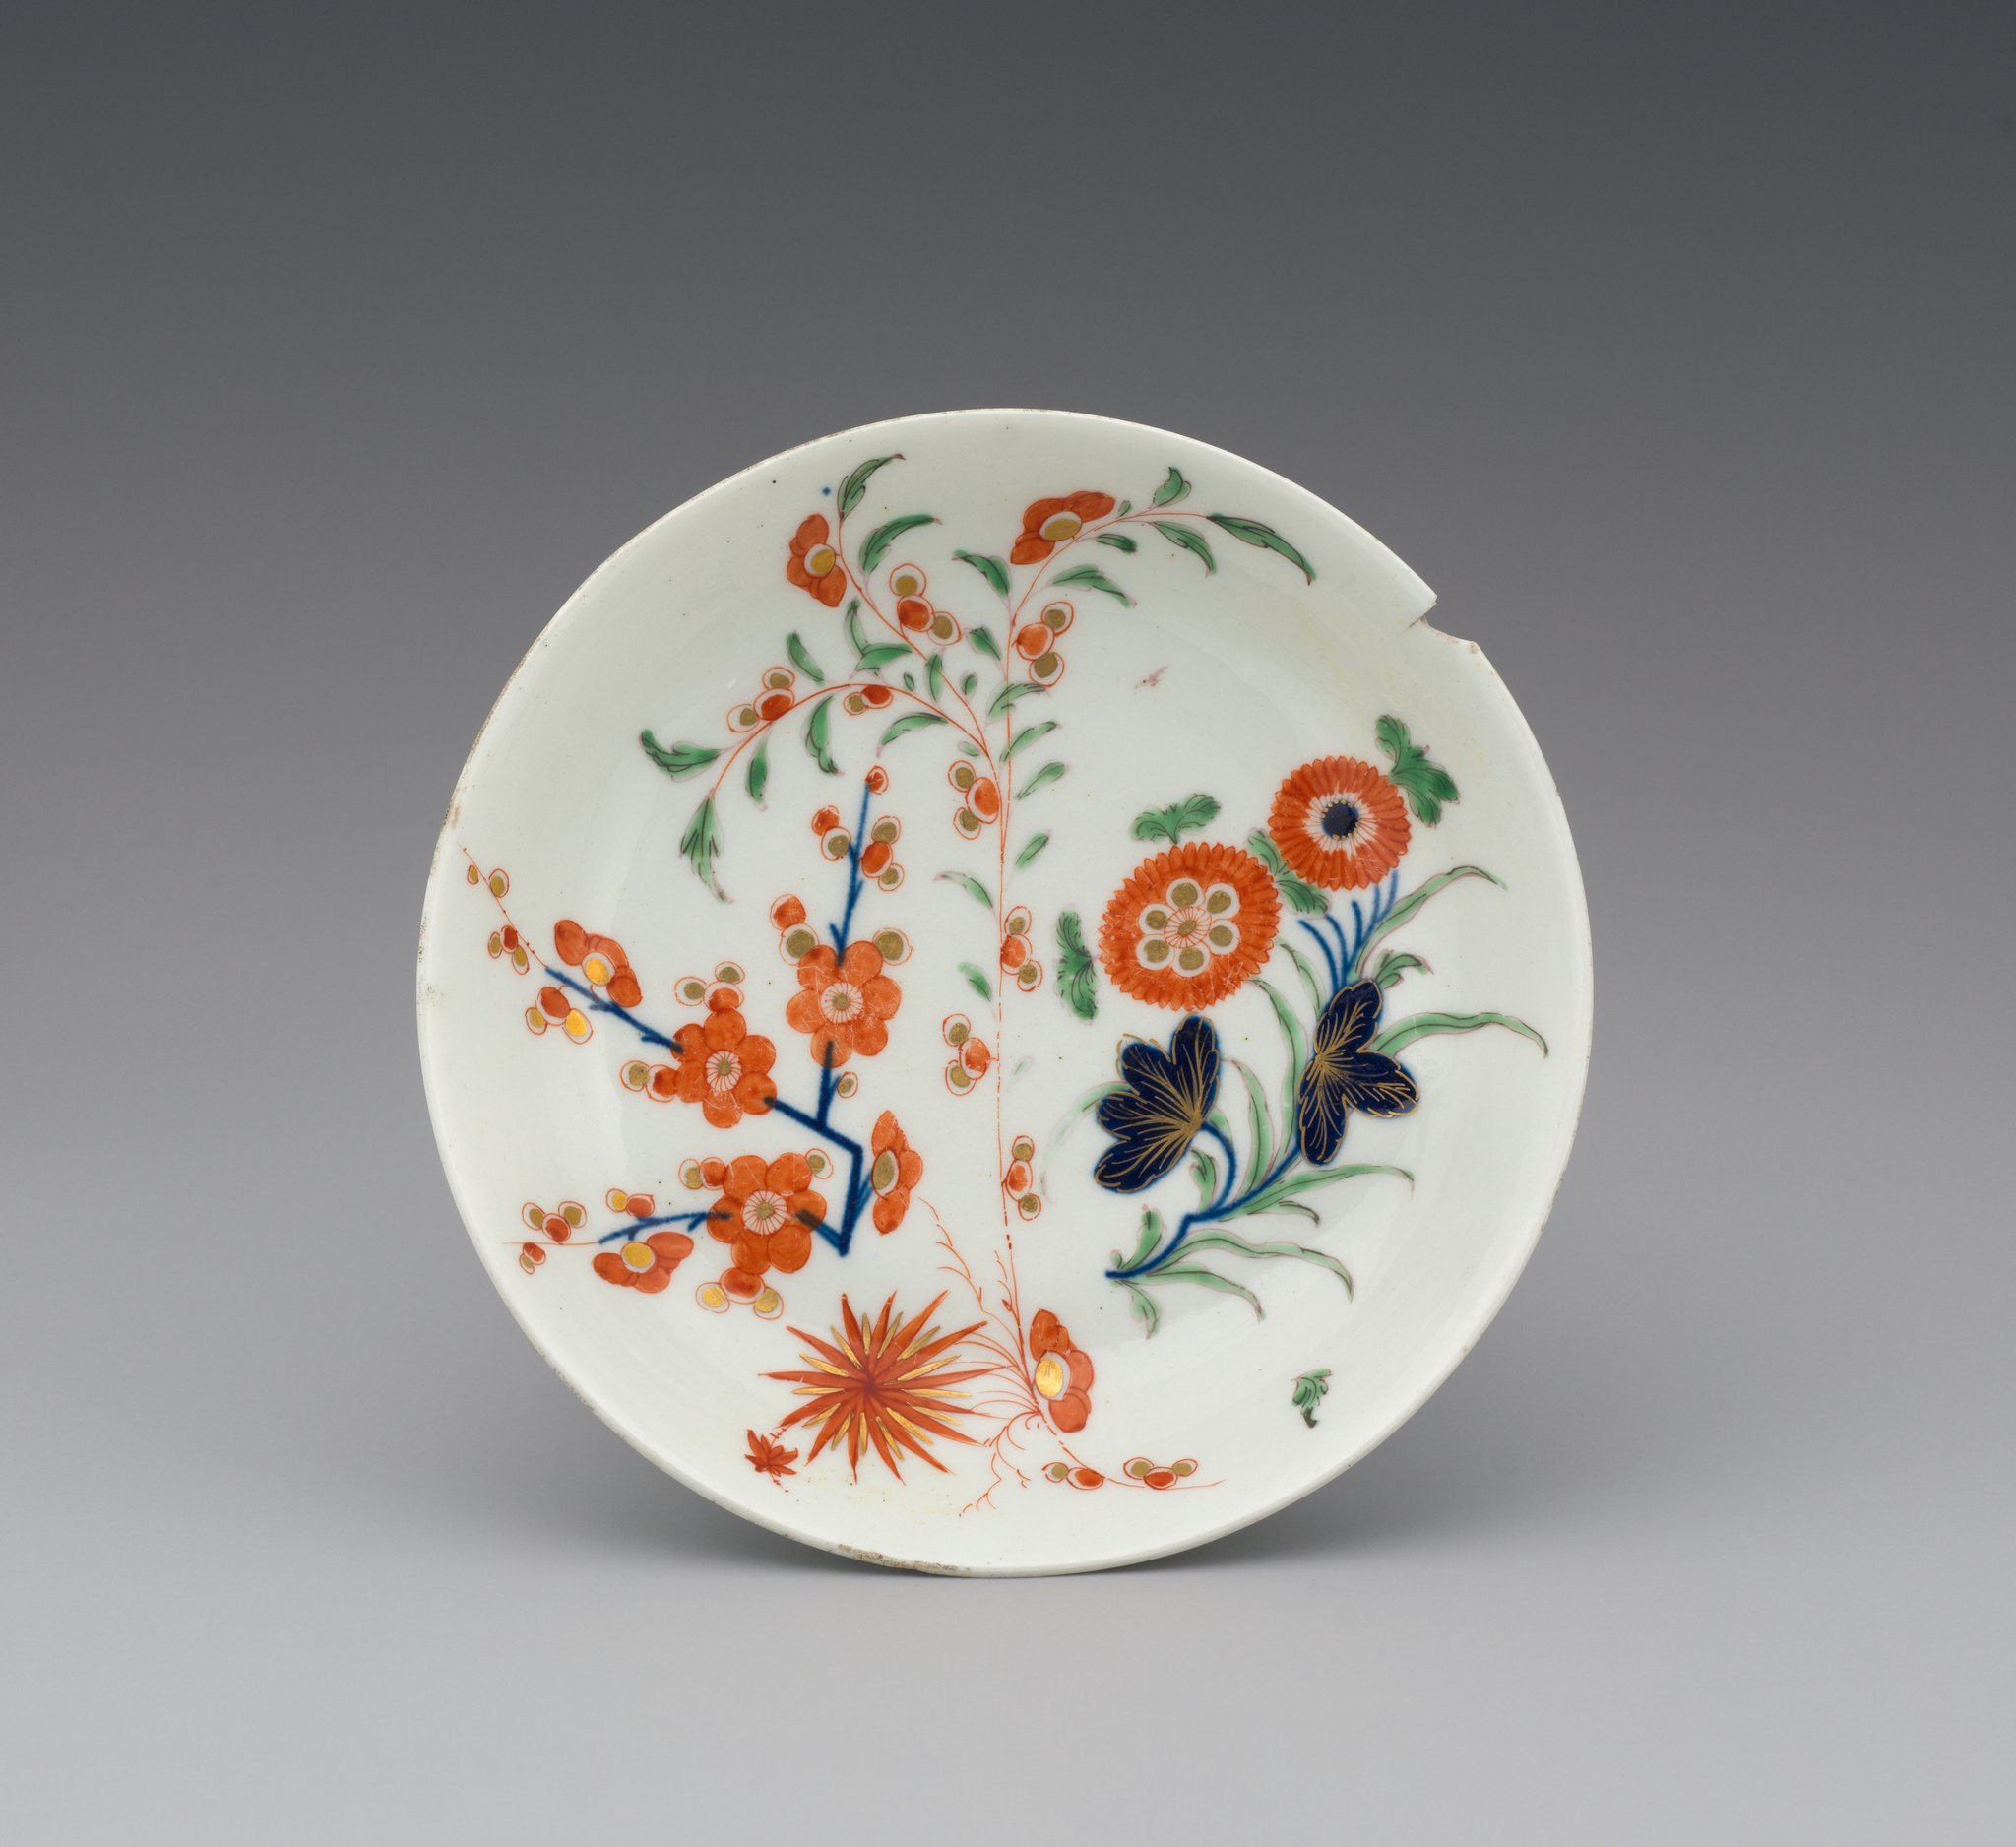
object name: saucer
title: Saucer (part of a service)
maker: worcester factory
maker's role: factory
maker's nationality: british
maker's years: 1751-2008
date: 1765-1770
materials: soft paste porcelain